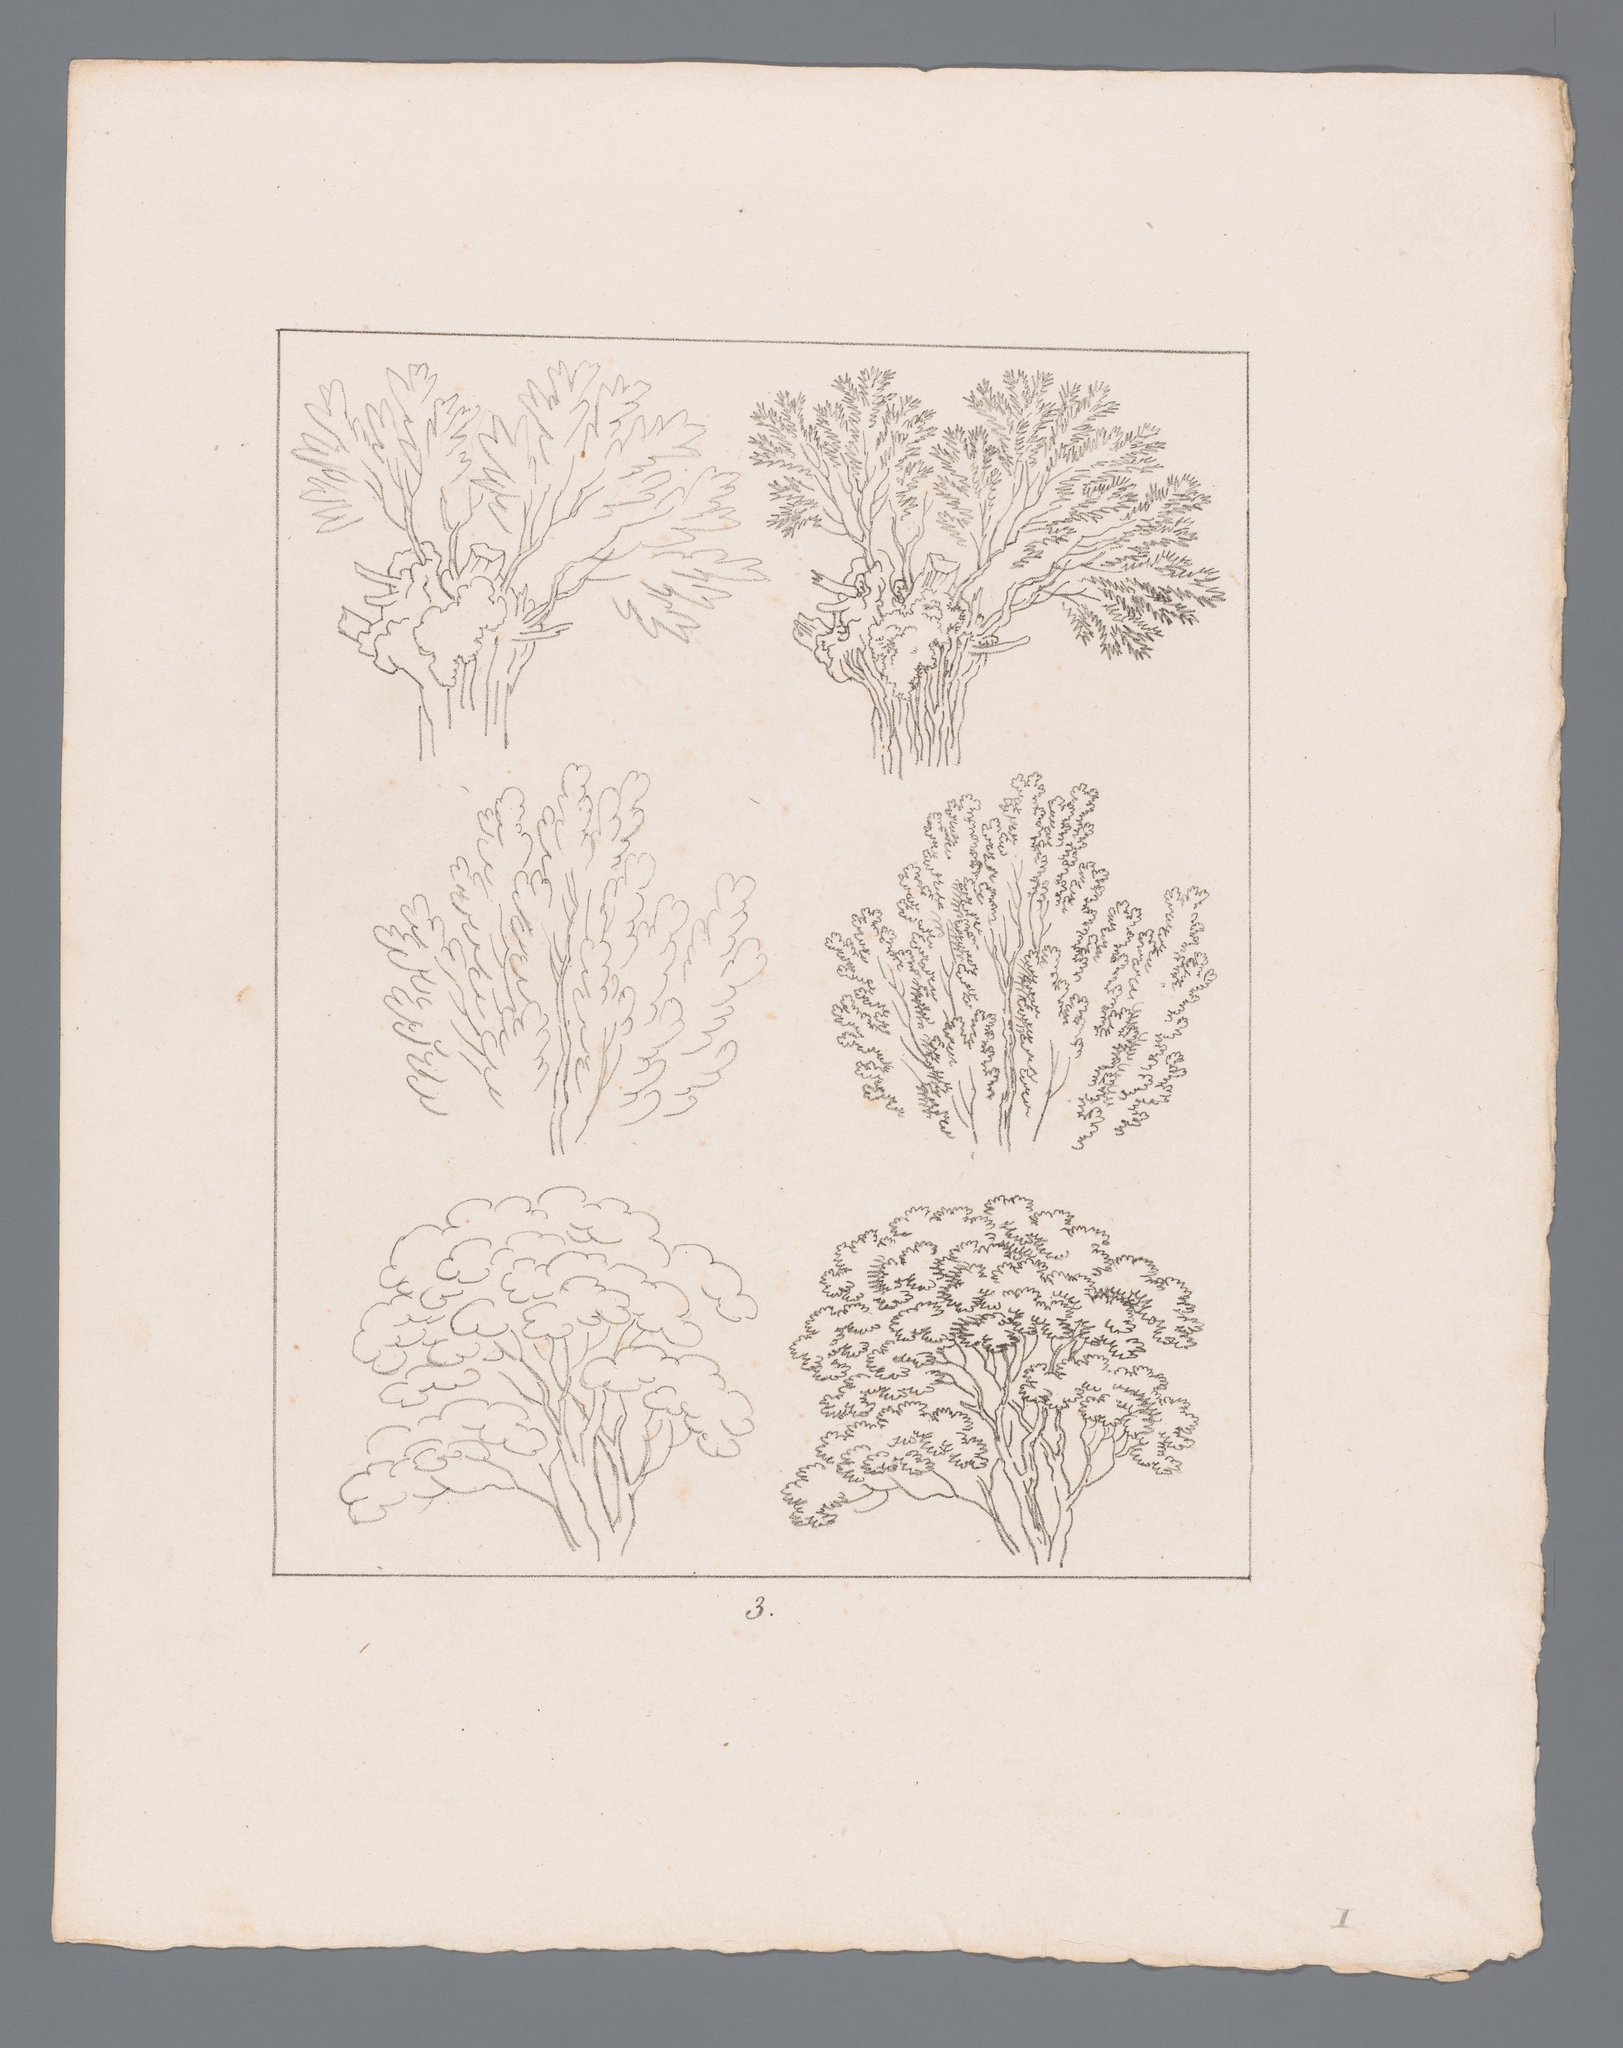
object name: print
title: Vorlagen für Landschaft-Zeichner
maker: max josef wagenbauer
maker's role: print maker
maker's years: 1774-1829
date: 1823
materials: paper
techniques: lithograph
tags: trees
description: Onderdeel van een tweedelige serie waarvan het tweede deel bestaat uit een titelprent en twaalf voorstellingen van takken, bladeren, bomen en landschappen.